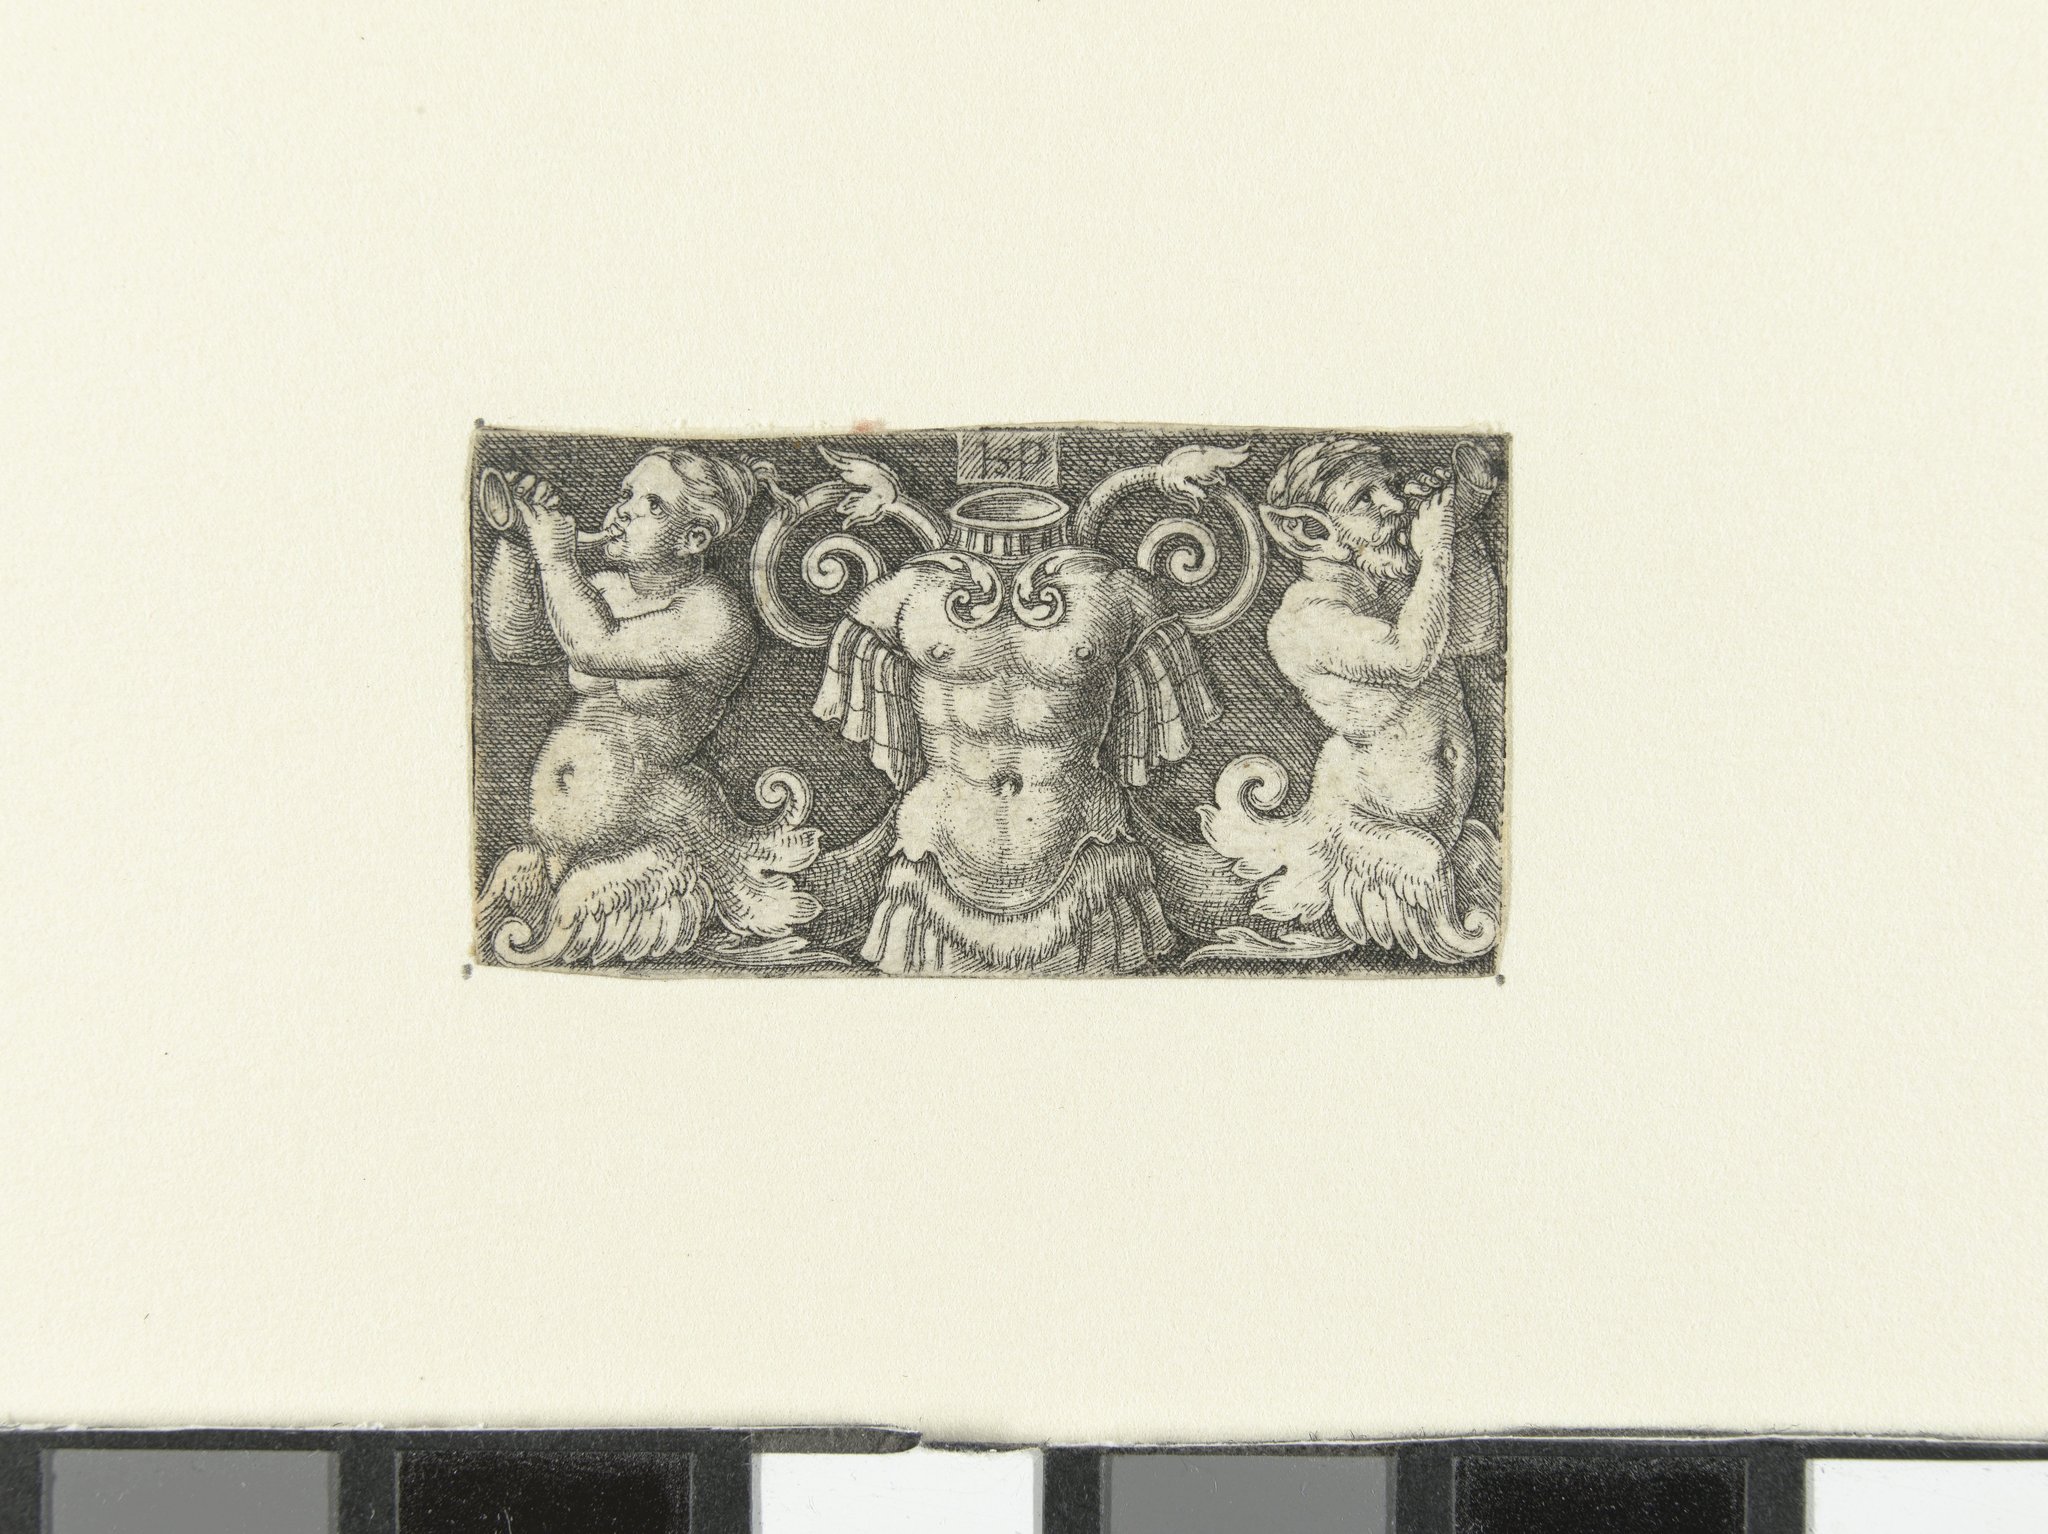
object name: print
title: Friezen met grotesken, putti en bladranken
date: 1510-1550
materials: paper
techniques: engraving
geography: germany